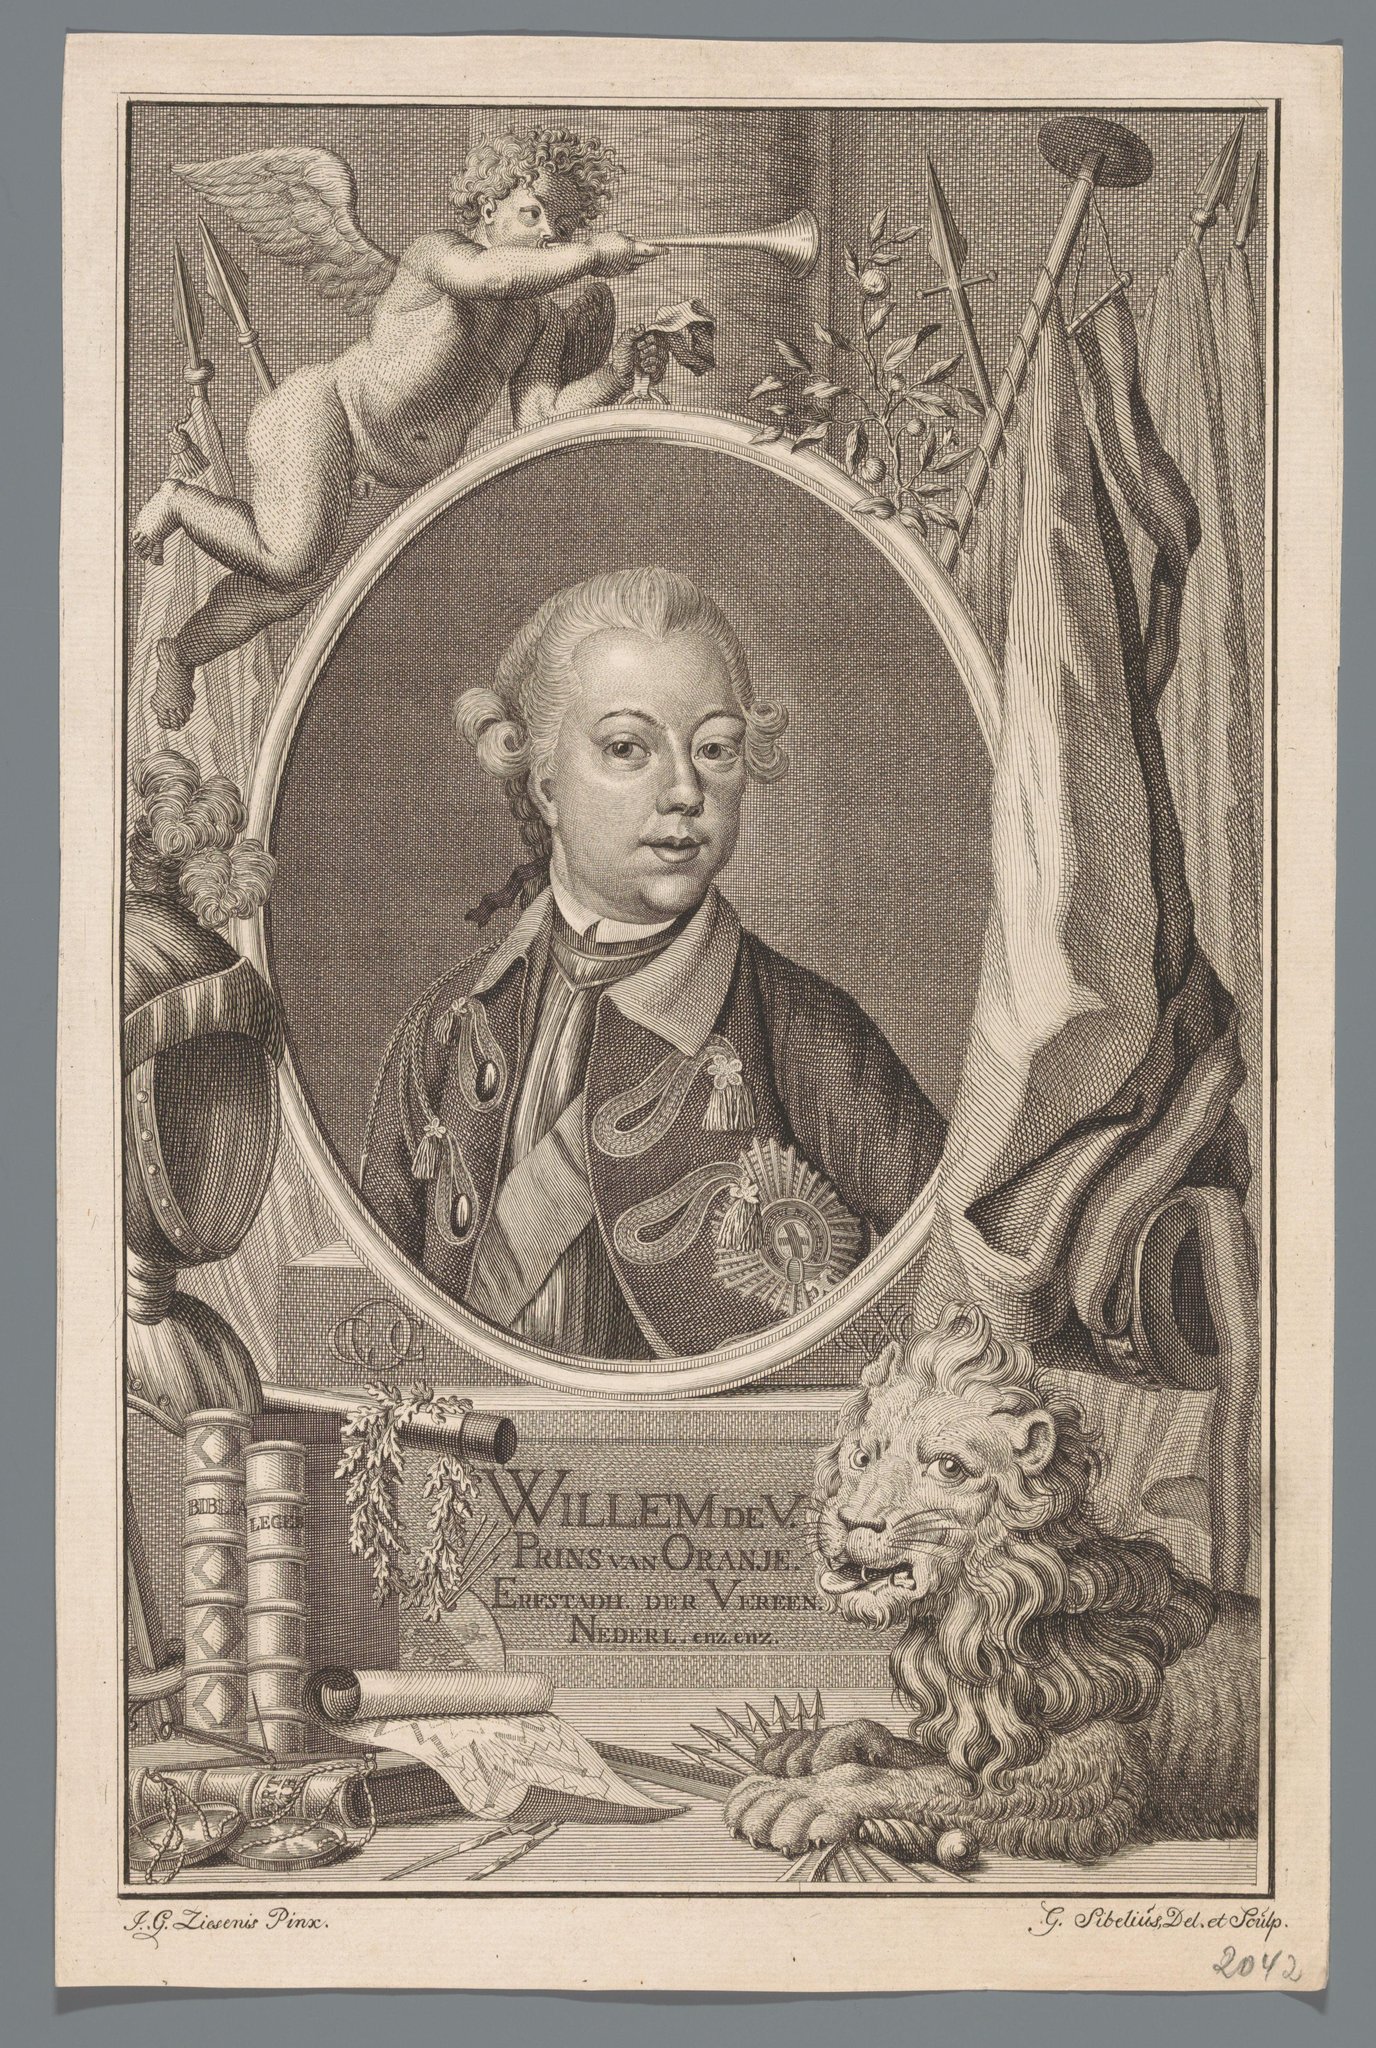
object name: print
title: Portret van Willem V, prins van Oranje-Nassau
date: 1755-1785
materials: paper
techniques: engraving, etching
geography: northern netherlands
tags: the hague, william v (prince of orange), knighthood order (garter) - insignia of a knighthood order, e.g.: badge, chain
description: Portret van Willem V in een ovaal. Rondom ligt een aantal allegorische objecten, waaronder een helm, een weegschaal, een commandostaf en een lauwerkrans. Op een voetstuk zijn naam en titels.